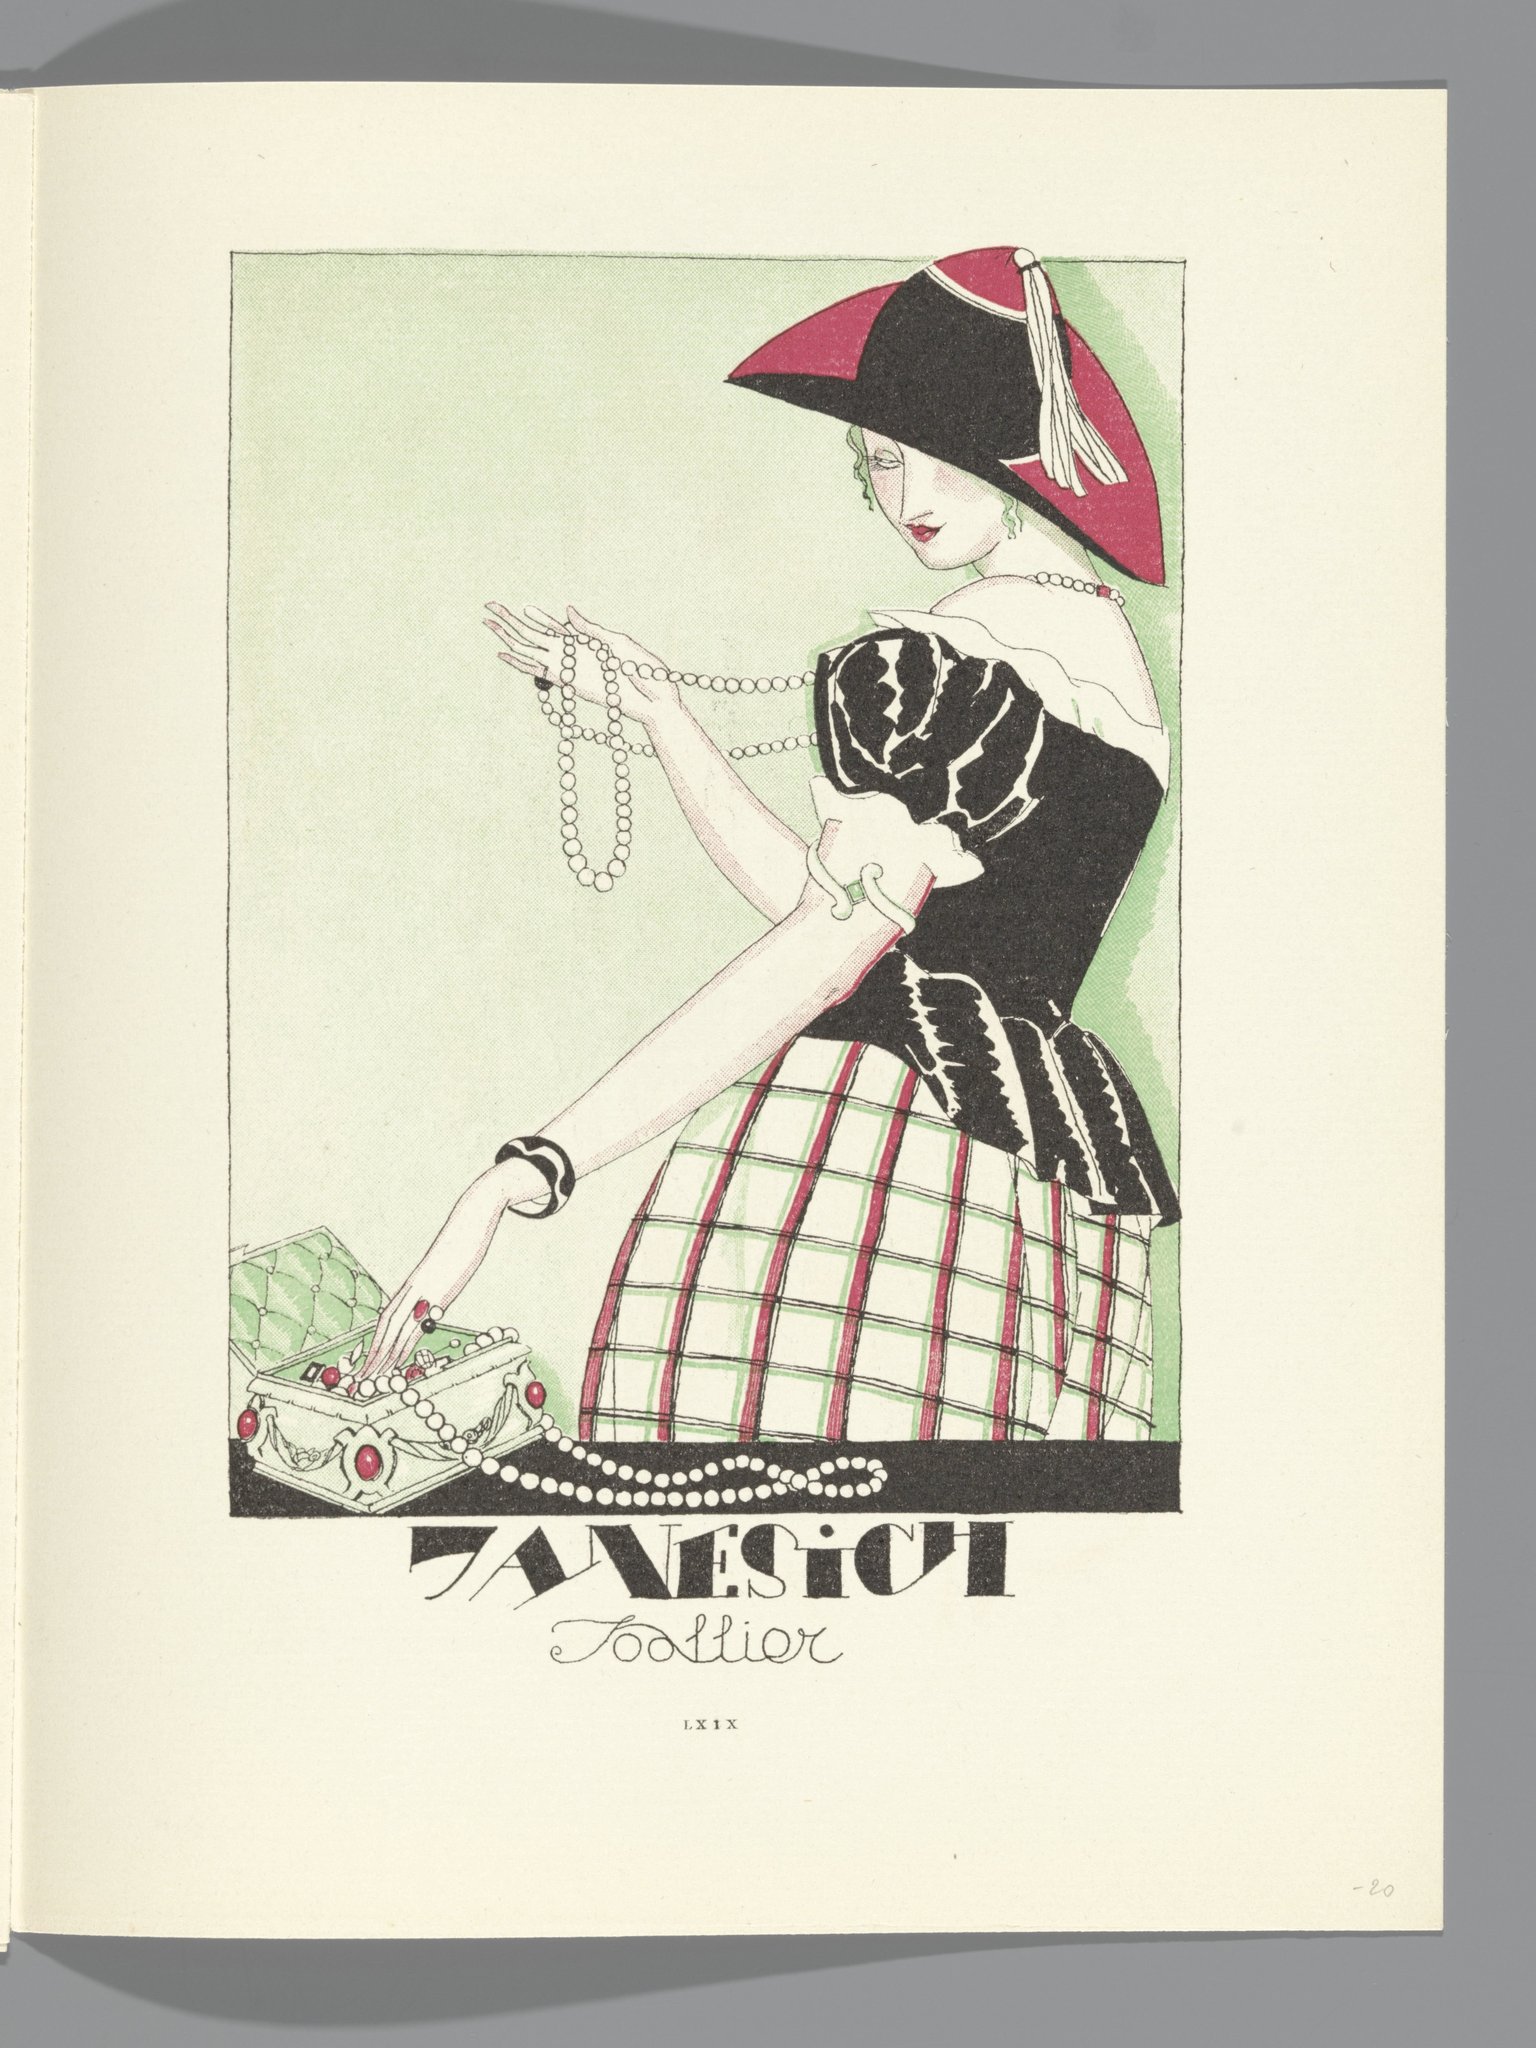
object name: fashion print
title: Gazette du Bon Ton. Art – Modes & Frivolités: Advertising Material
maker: lucien vogel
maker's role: publisher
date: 1920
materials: paper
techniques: printing, letterpress printing, photochemical processes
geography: paris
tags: ornaments, jewels (+ women's clothes), jewel-box (+ women's clothes), fashion plates, head-gear: hat (+ women's clothes)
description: The Gazette du Bon Ton also included advertisements: for shops selling fashions and fabrics, jewellers, hairdressers and beauticians. These ads were also well designed; many were drawn by the same artists who supplied the fashion plates. Even the smallest ads were presented with flair and in a style that was befitting of the whole.